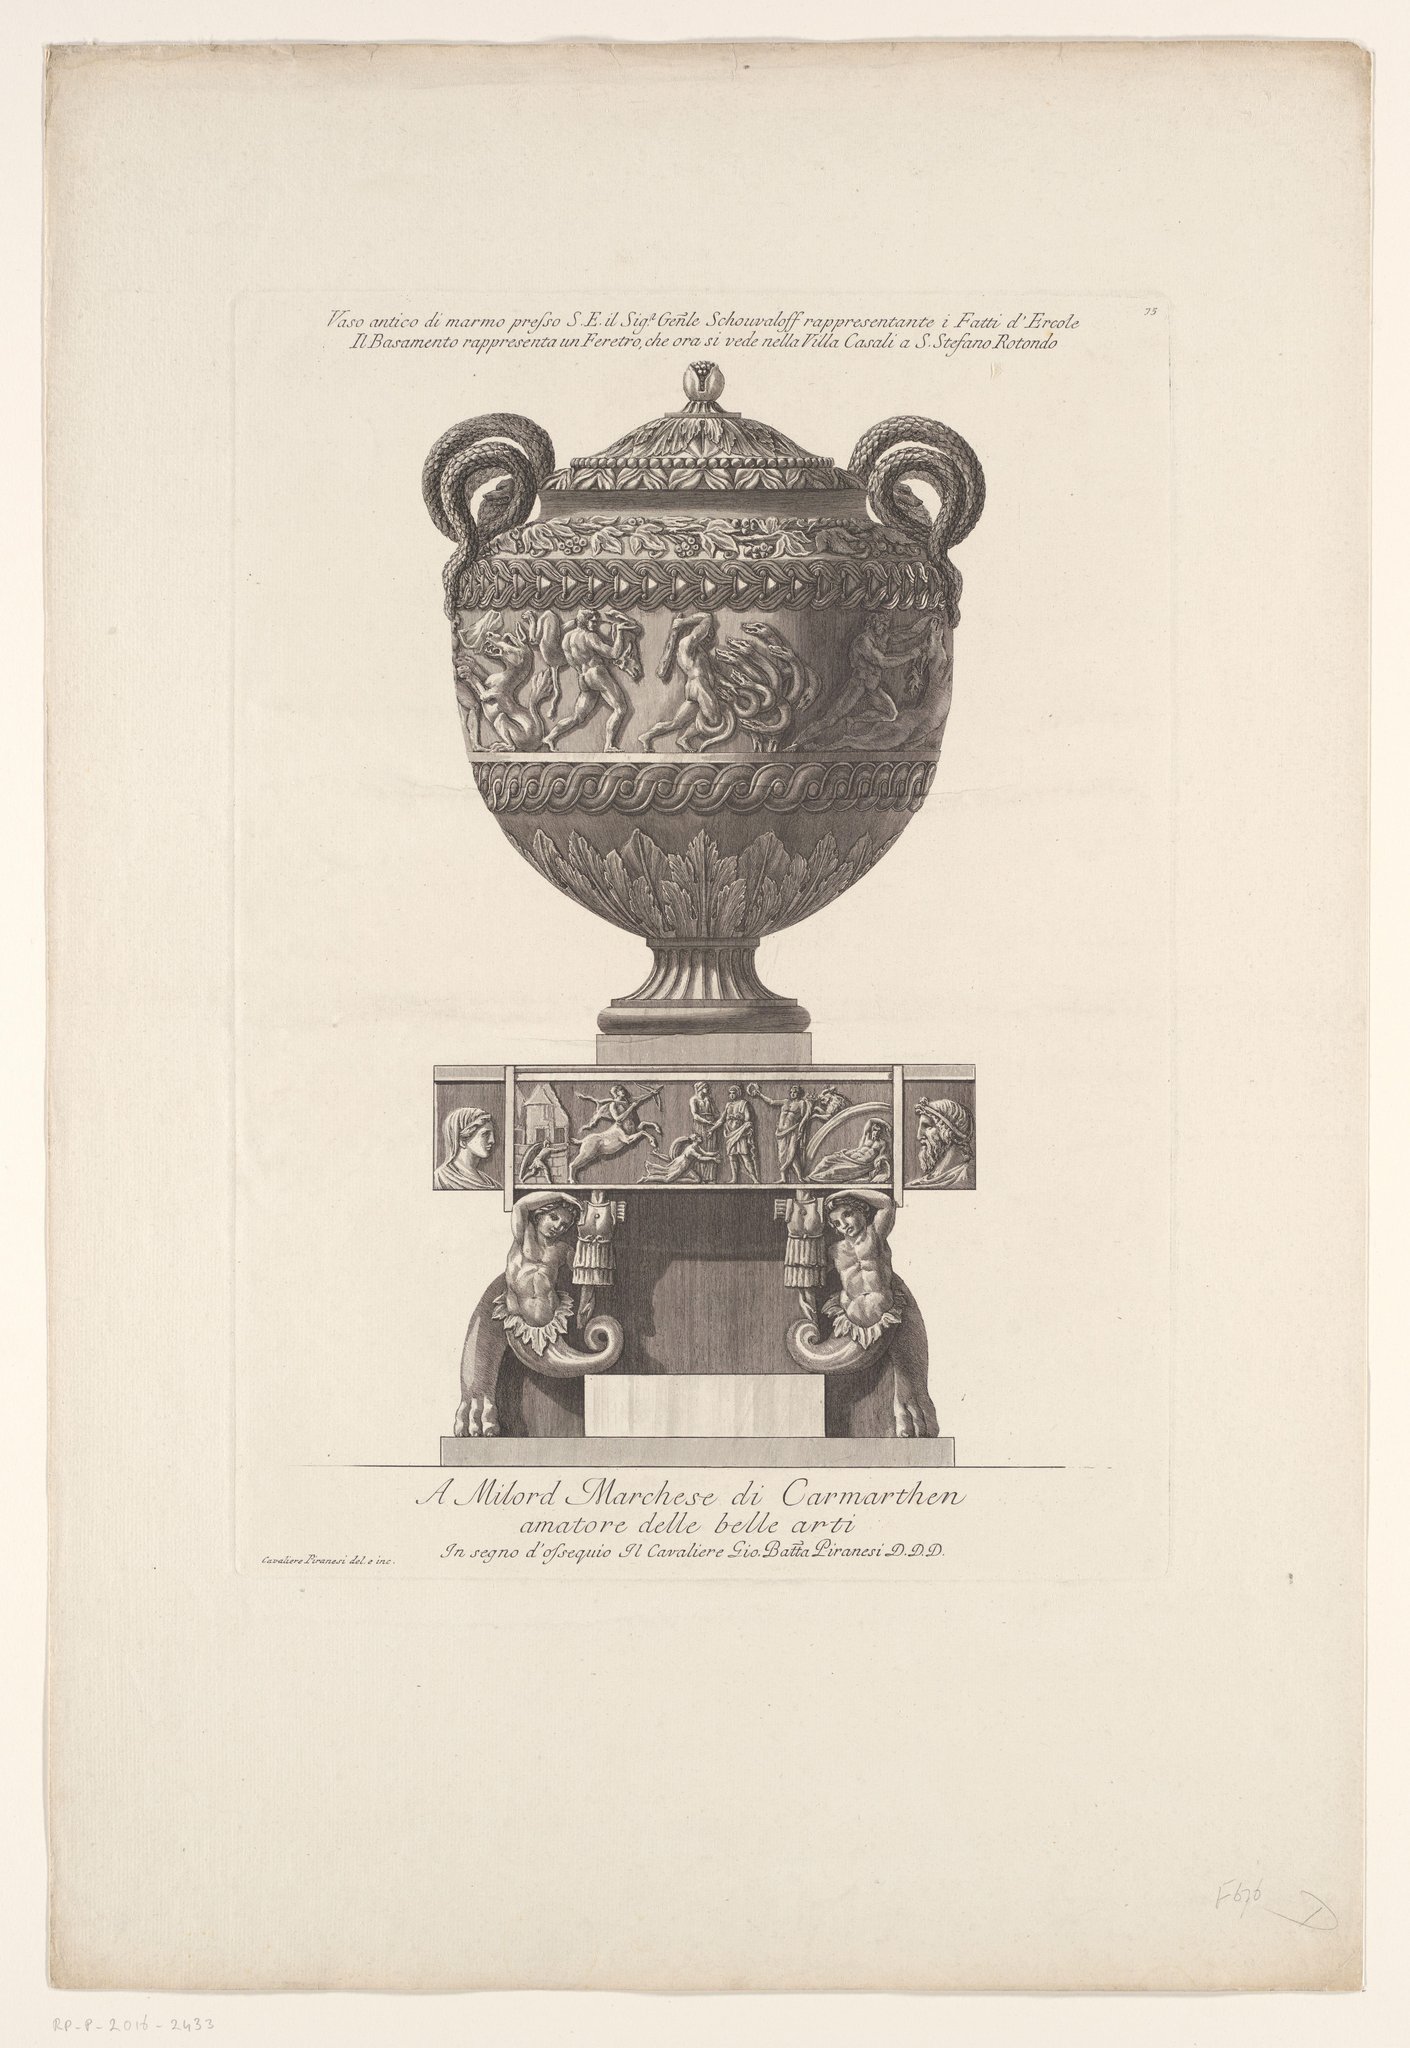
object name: ornament print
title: Vaas met de werken van Hercules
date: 1778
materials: paper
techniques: etching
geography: rome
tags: vase ~ ornament, most important deeds of hercules: the twelve labours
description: De 'Vasi'-reeks telt 110 prenten, verspreid over twee volumes met elk een eigen titelprent. Piranesi werd voor deze reeks geholpen door verschillende assistenten uit zijn werkplaats, waaronder zijn zoon Francesco die ook nog eens 8 platen toevoegde aan de reeks in 1779-1780.